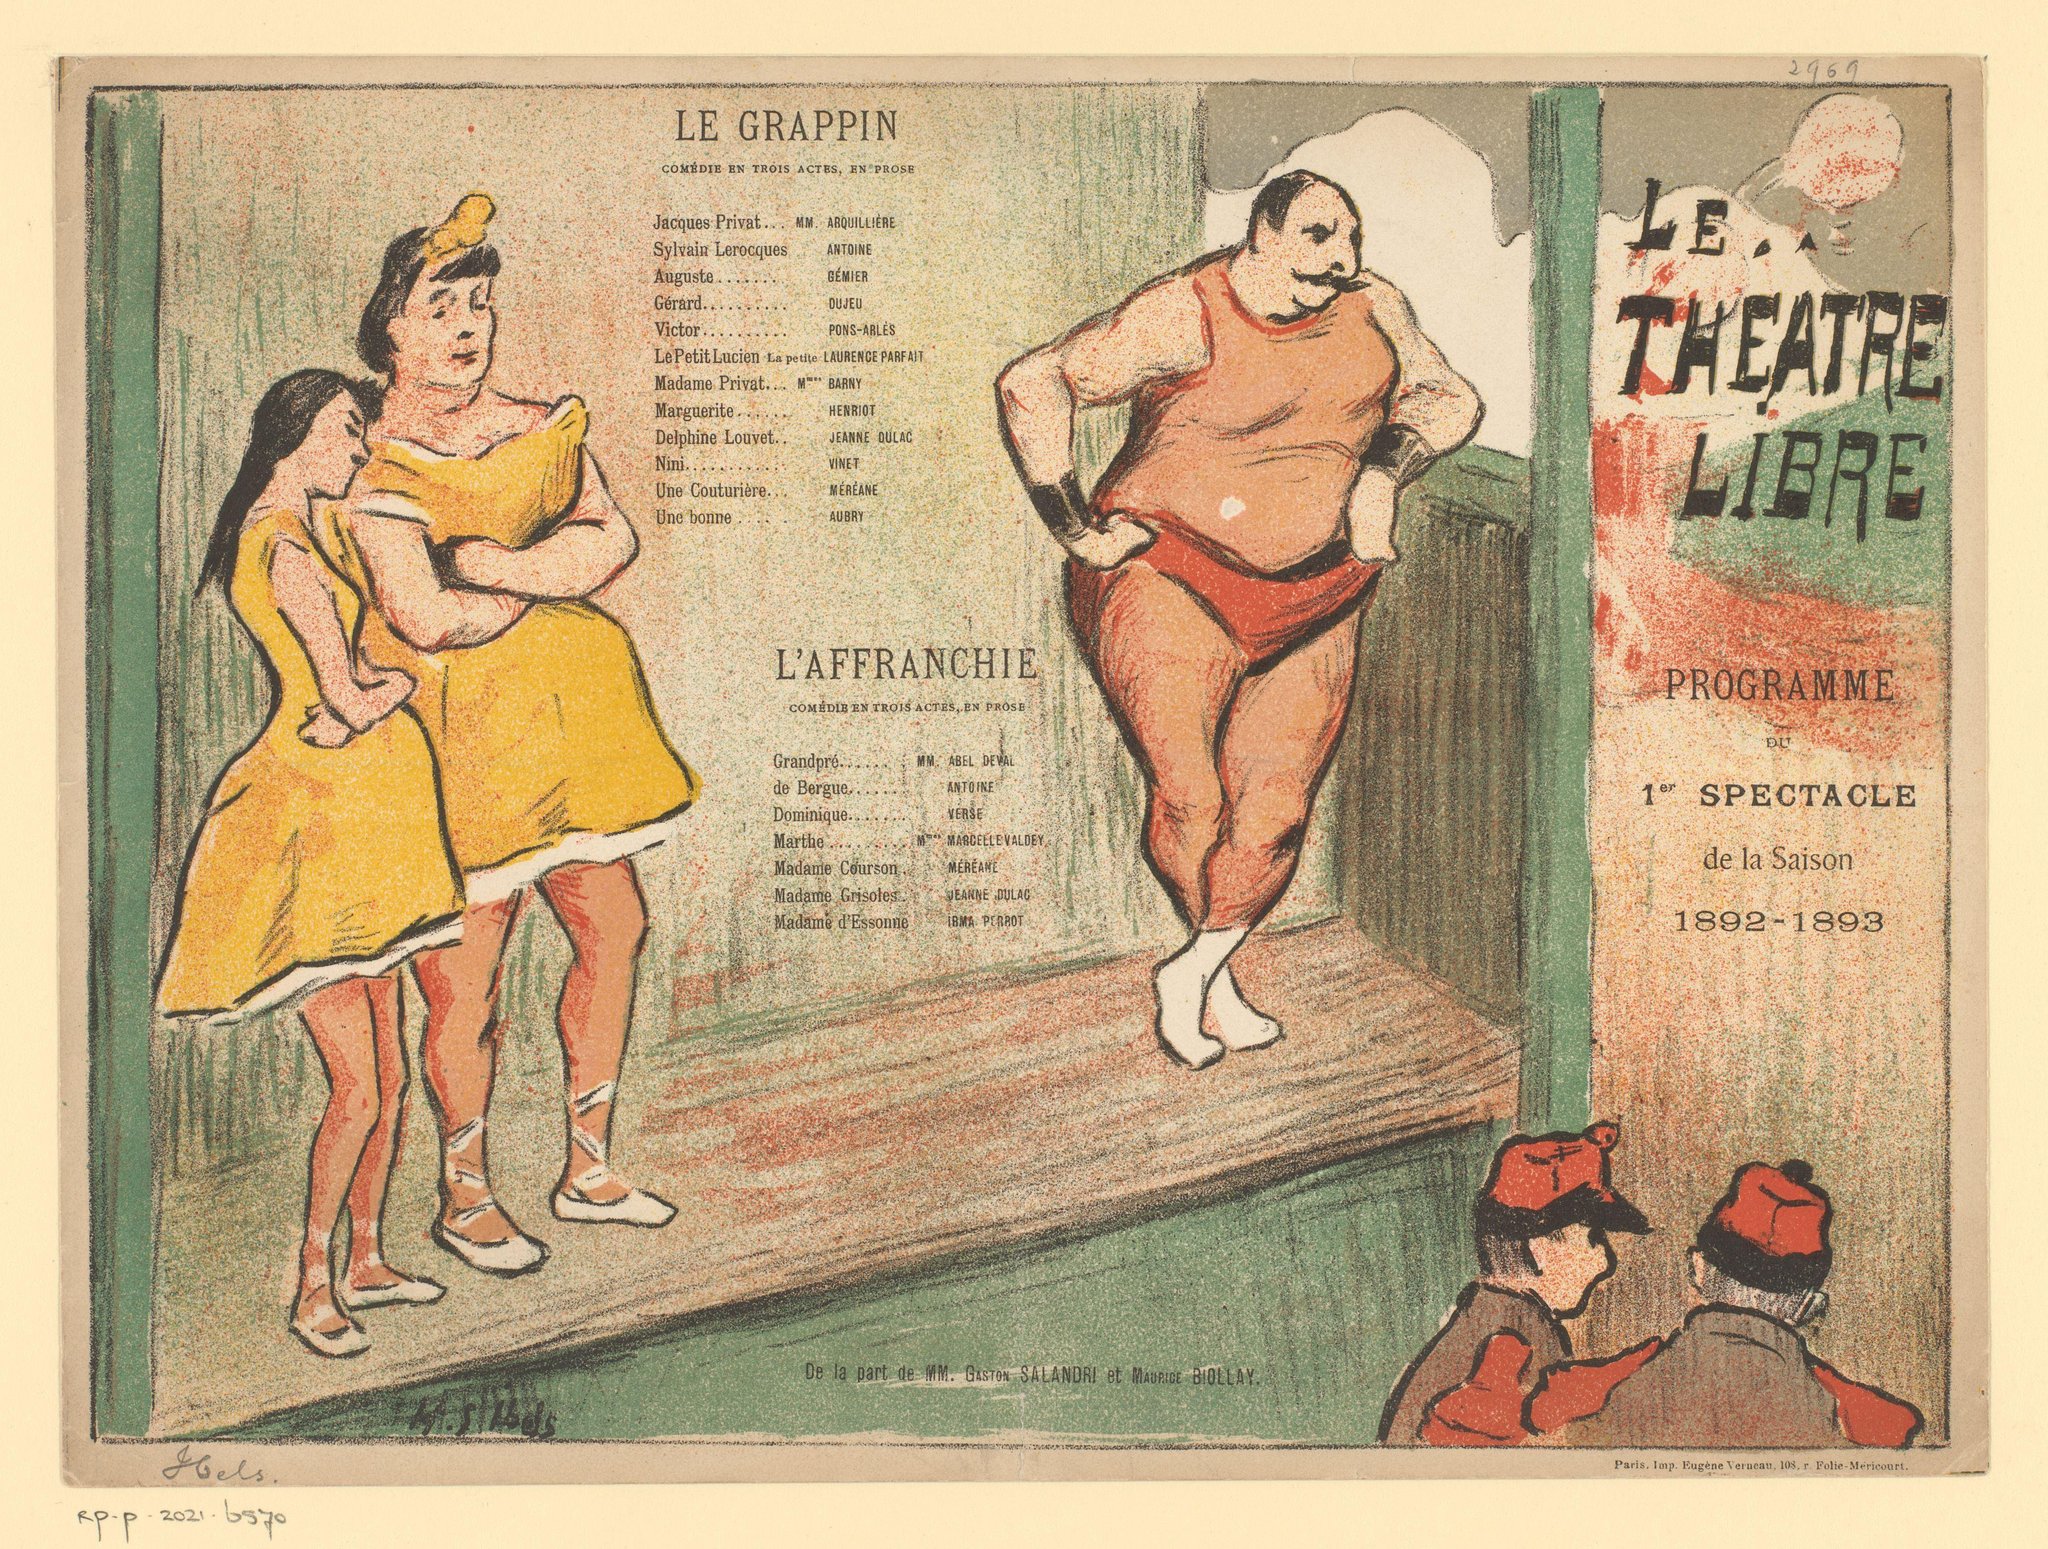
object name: print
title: Programma voor de toneelvoorstellingen 'Le grappin' en 'L'affranchie' bij het Théâtre Libre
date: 1892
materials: paper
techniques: lithograph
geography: paris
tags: performance, group of actors, troupe; actors on the stage, paris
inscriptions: date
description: Een man en twee vrouwen op een verhoging waarvoor twee soldaten langslopen. Met de namen van de stukken en hun personages met de acteurs van de eerste voorstelling uit het seizoen 1892-1893.